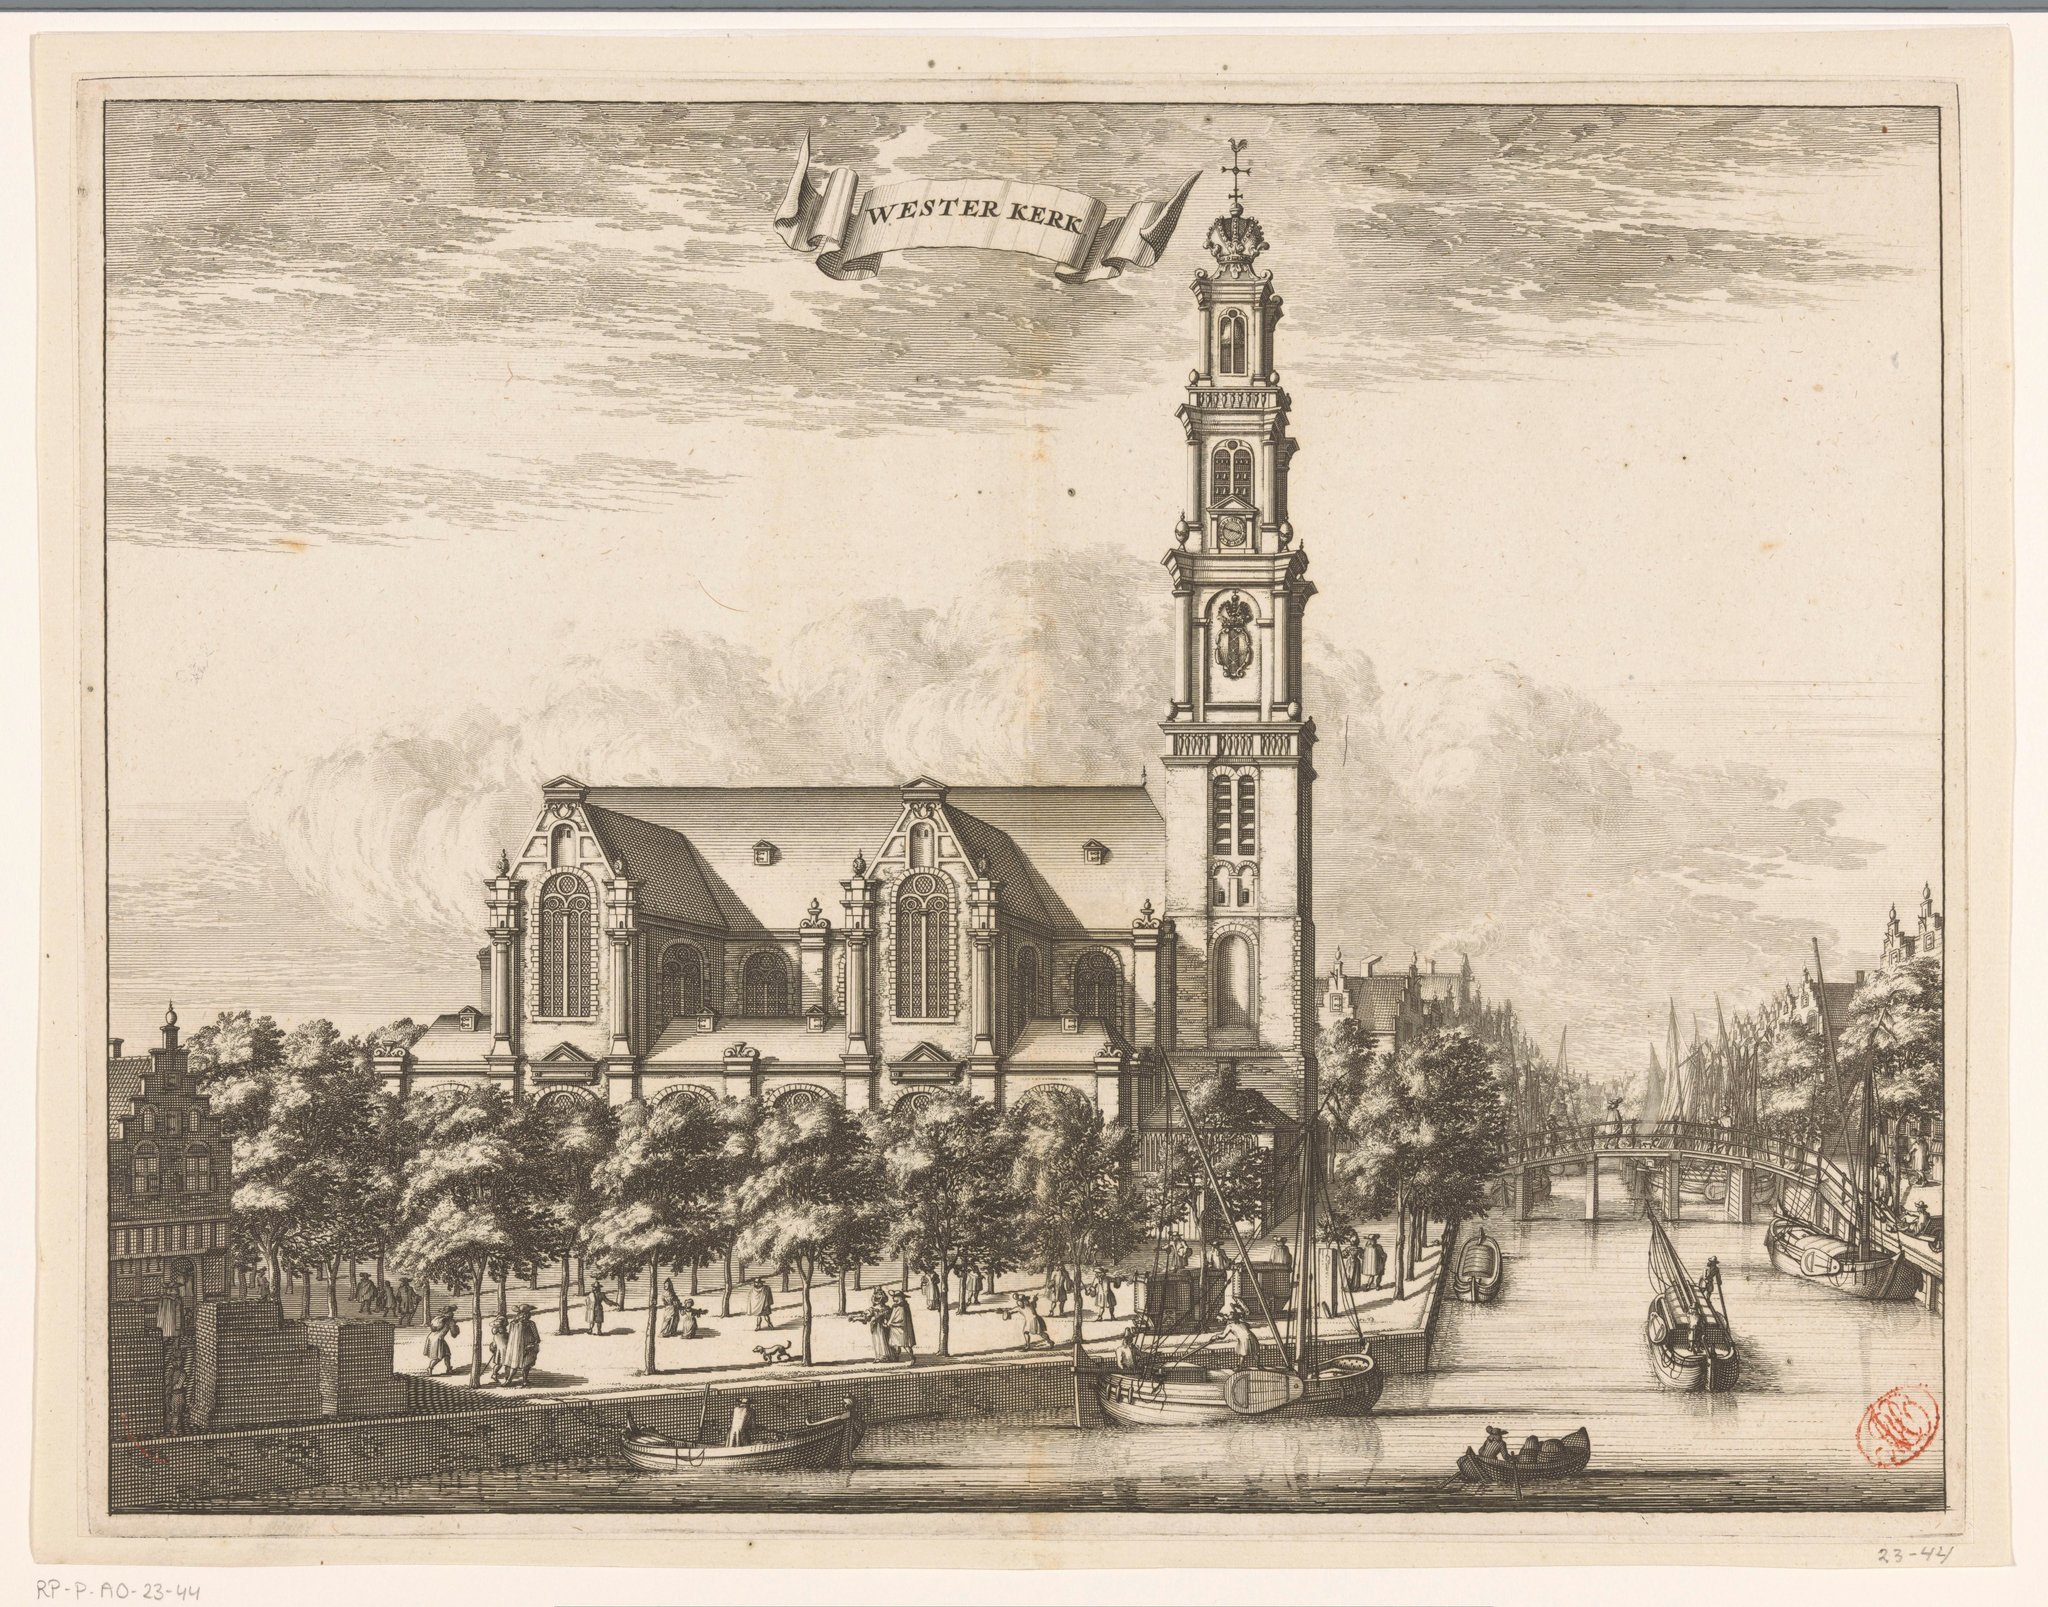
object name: print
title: Gezicht op de Westerkerk te Amsterdam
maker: Anonymous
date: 1693-1694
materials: paper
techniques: engraving, etching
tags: bridge in city across river, canal, etc. (+ city(-scape) with figures, staffage), sailing-ship, sailing-boat, church (exterior), rowing-boat, canoe, etc., canals, waters (in city), street (+ city(-scape) with figures, staffage)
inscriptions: collector's mark: Lugt 195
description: Huidige staat van prent ook gebruikt in: Commelin, Caspar. Beschryvinge van Amsterdam, desselfs eerste oorspronk uyt den Huyse (…). 2 delen. Amsterdam: Abraham Wolfgang, Gillis Janssonius van Waesberge, Johannes Janssonius van Waesberge II, weduwe Dirk Boom I, Hendrick Boom en Rembertus Goethals, 1693. En in: Commelin, Caspar. Beschryvinge van Amsterdam, zynde een naukeurige verhandelinge van desselfs eerste oorspronk uyt (…). 2 delen. Amsterdam: weduwe Aart Dircksz Oossaan, 1694. Latere staat ook gebruikt in: Commelin, Caspar. Beschryvinge van Amsterdam, zynde een naukeurige verhandelinge van desselfs eerste oorspronk uyt (…). 2 delen. 2e druk. Amsterdam: Andries van Damme, Johannes Ratelband, weduwe A. van Aaltwyk en Hermanus Uytwerf, 1726.